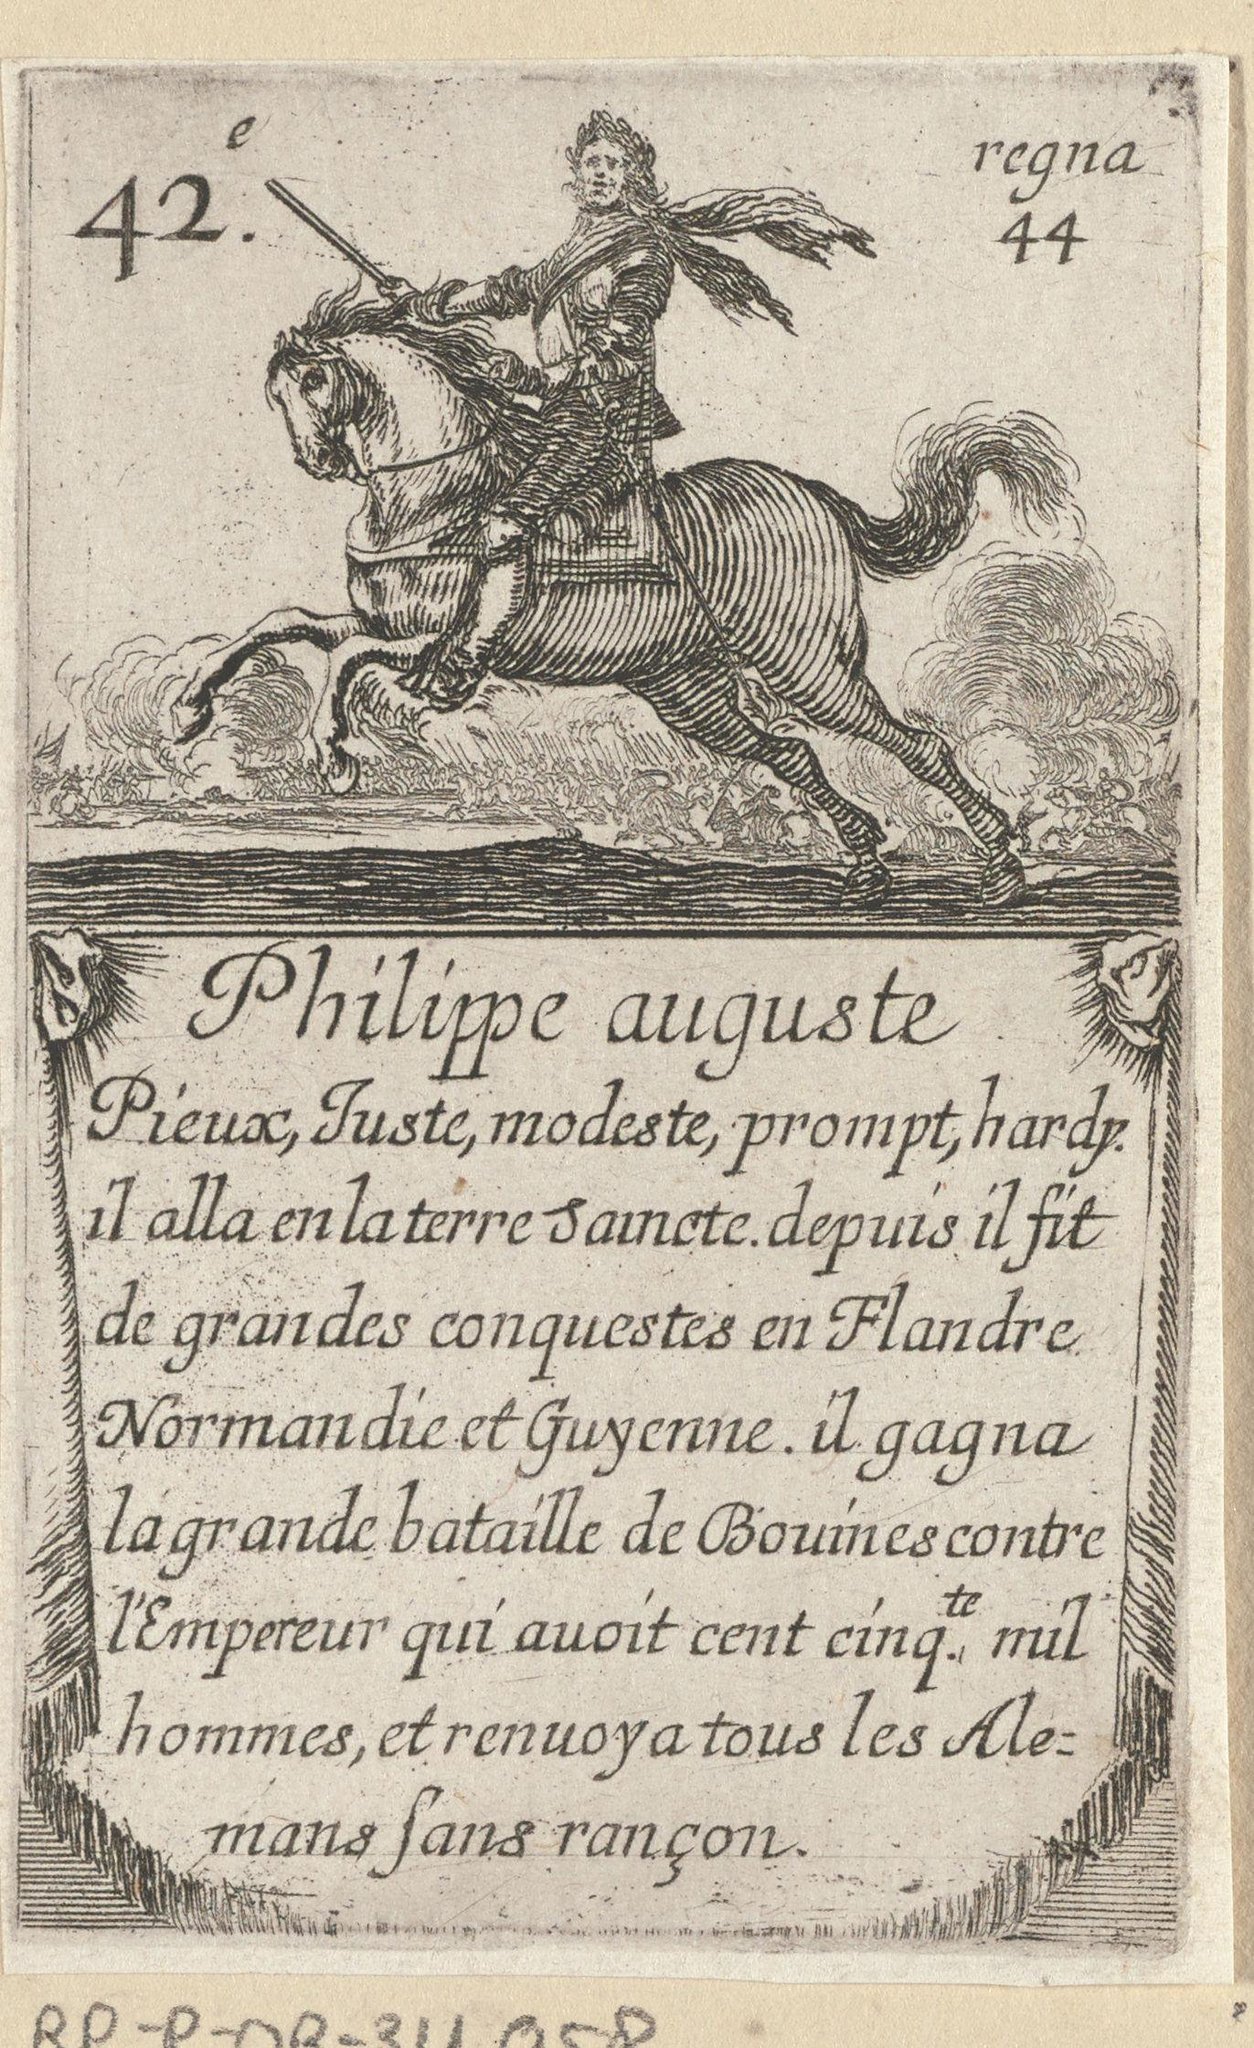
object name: playing card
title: Philippe Auguste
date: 1620-1664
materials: paper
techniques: etching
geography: paris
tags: paris, ruler, sovereign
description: Deze prent maakt deel uit van een kaartspel met 39 kaarten met voorstellingen van Franse koningen. De serie is uitgedacht door Jean Desmarests de Saint-Sorlin in opdracht van Kardinaal Mazarin. Het kaartspel werd gemaakt voor de jonge Lodewijk XIV, samen met het Jeu des Fables, Jeu des Reynes Renommées en Jeu de la géographie.